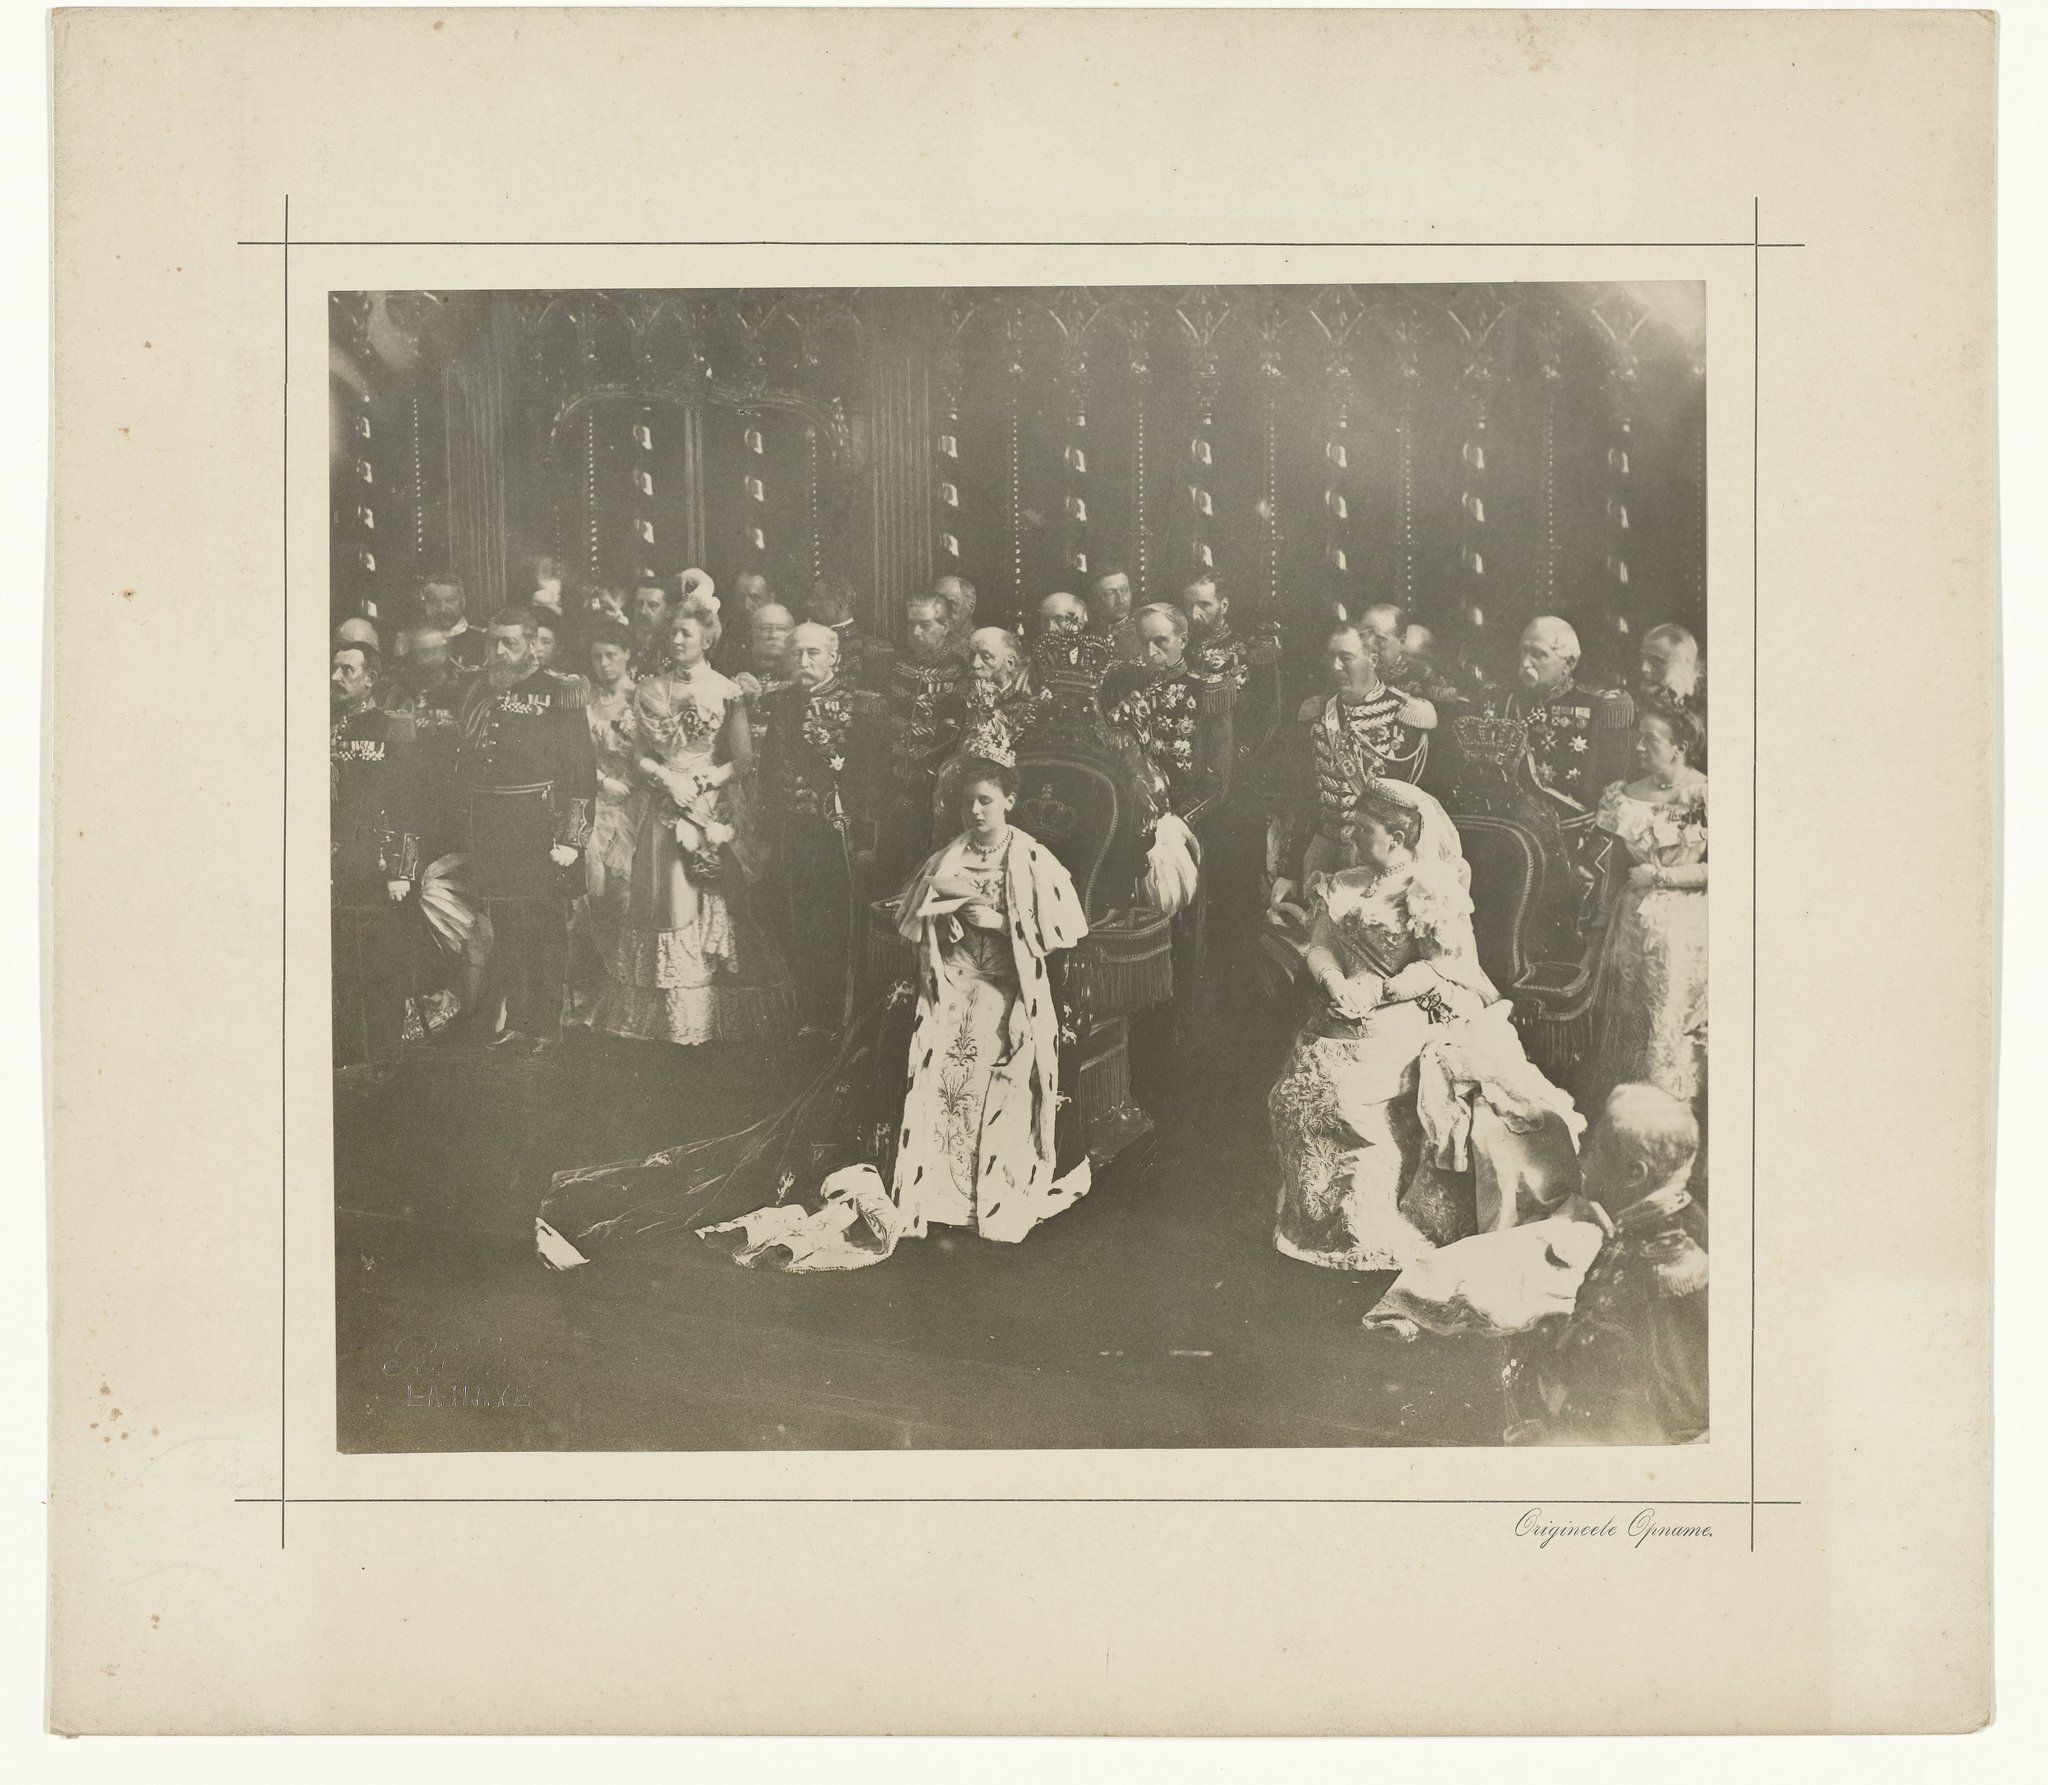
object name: photograph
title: R. Ebner La Haya, Origineele opname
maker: r. ebner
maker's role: fotograaf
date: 1898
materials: paper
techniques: gelatin silver print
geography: the hague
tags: the hague, print maker, wilhelmina of the netherlands, during the coronation, amsterdam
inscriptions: title: ‘R. Ebner La Haya, Origineele opname’